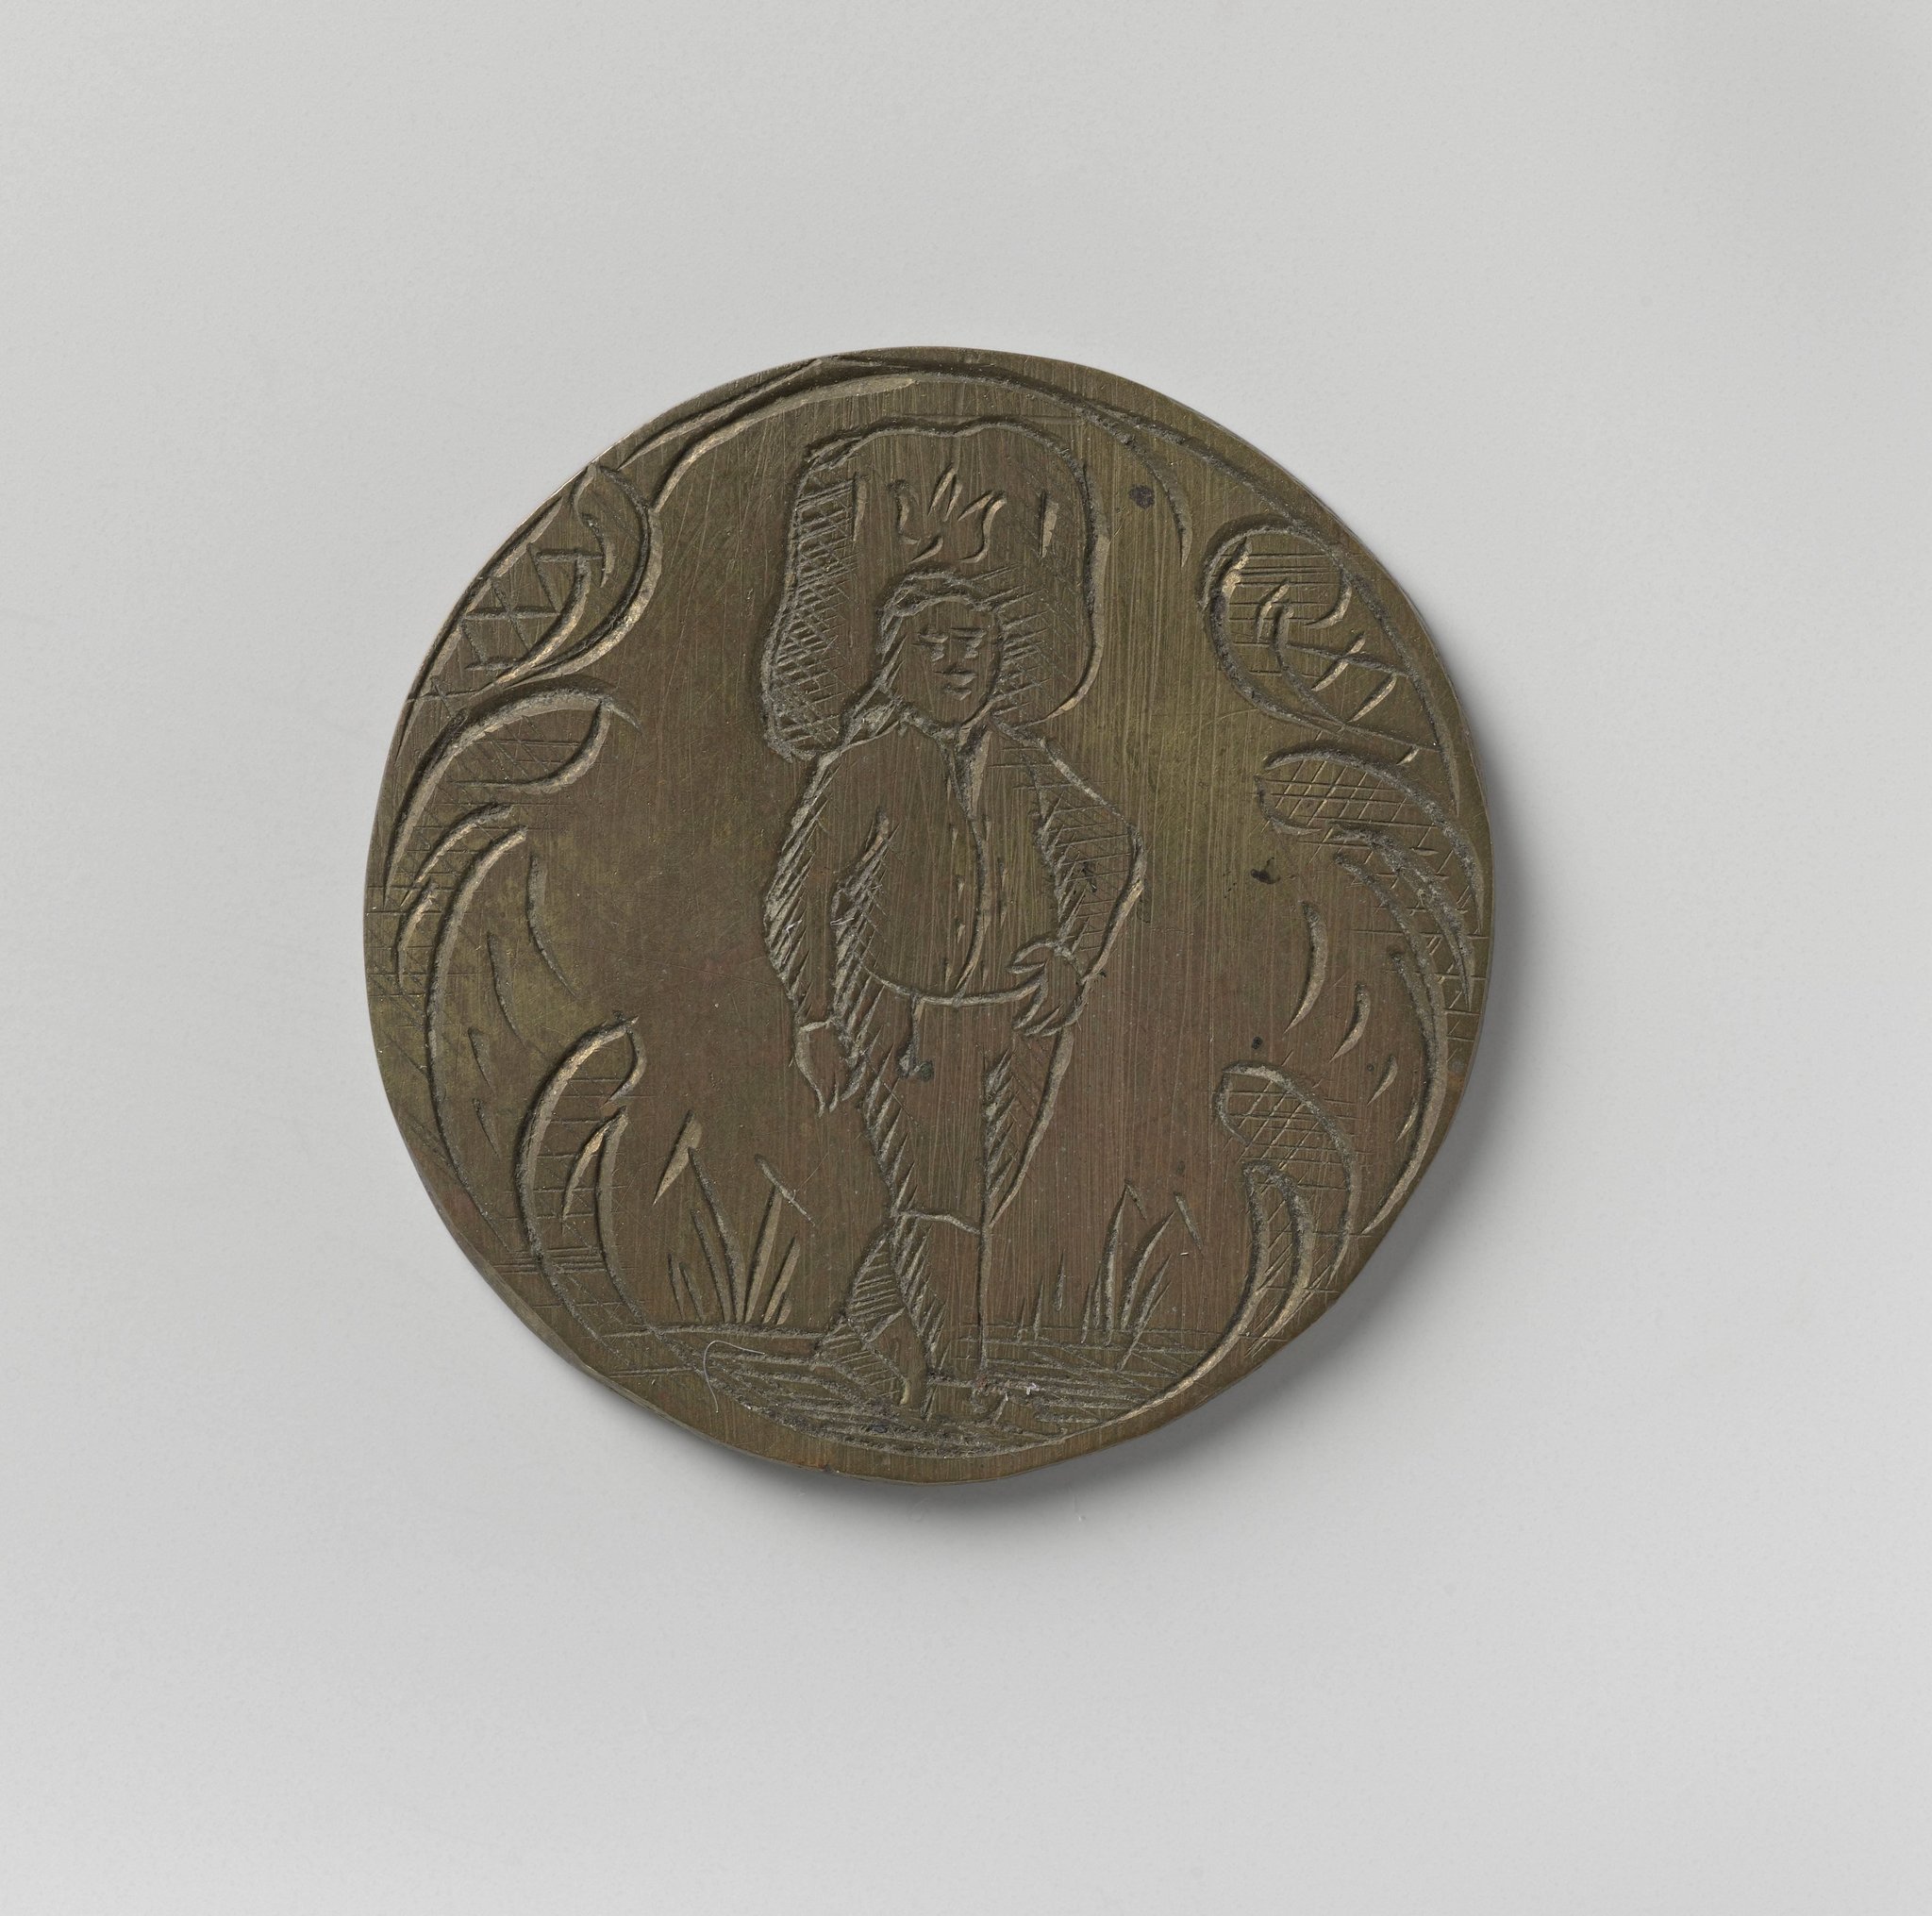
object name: medal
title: Korendragers- en -stortersgilde van Amsterdam, gildepenning van Pieter Keyser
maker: Anonymous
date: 1797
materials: brass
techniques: engraving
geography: amsterdam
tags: amsterdam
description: Messing penning. Voorzijde: lichtelijk naar rechts gewende man met last op hoofd binnen sierrand. Keerzijde: opschrift